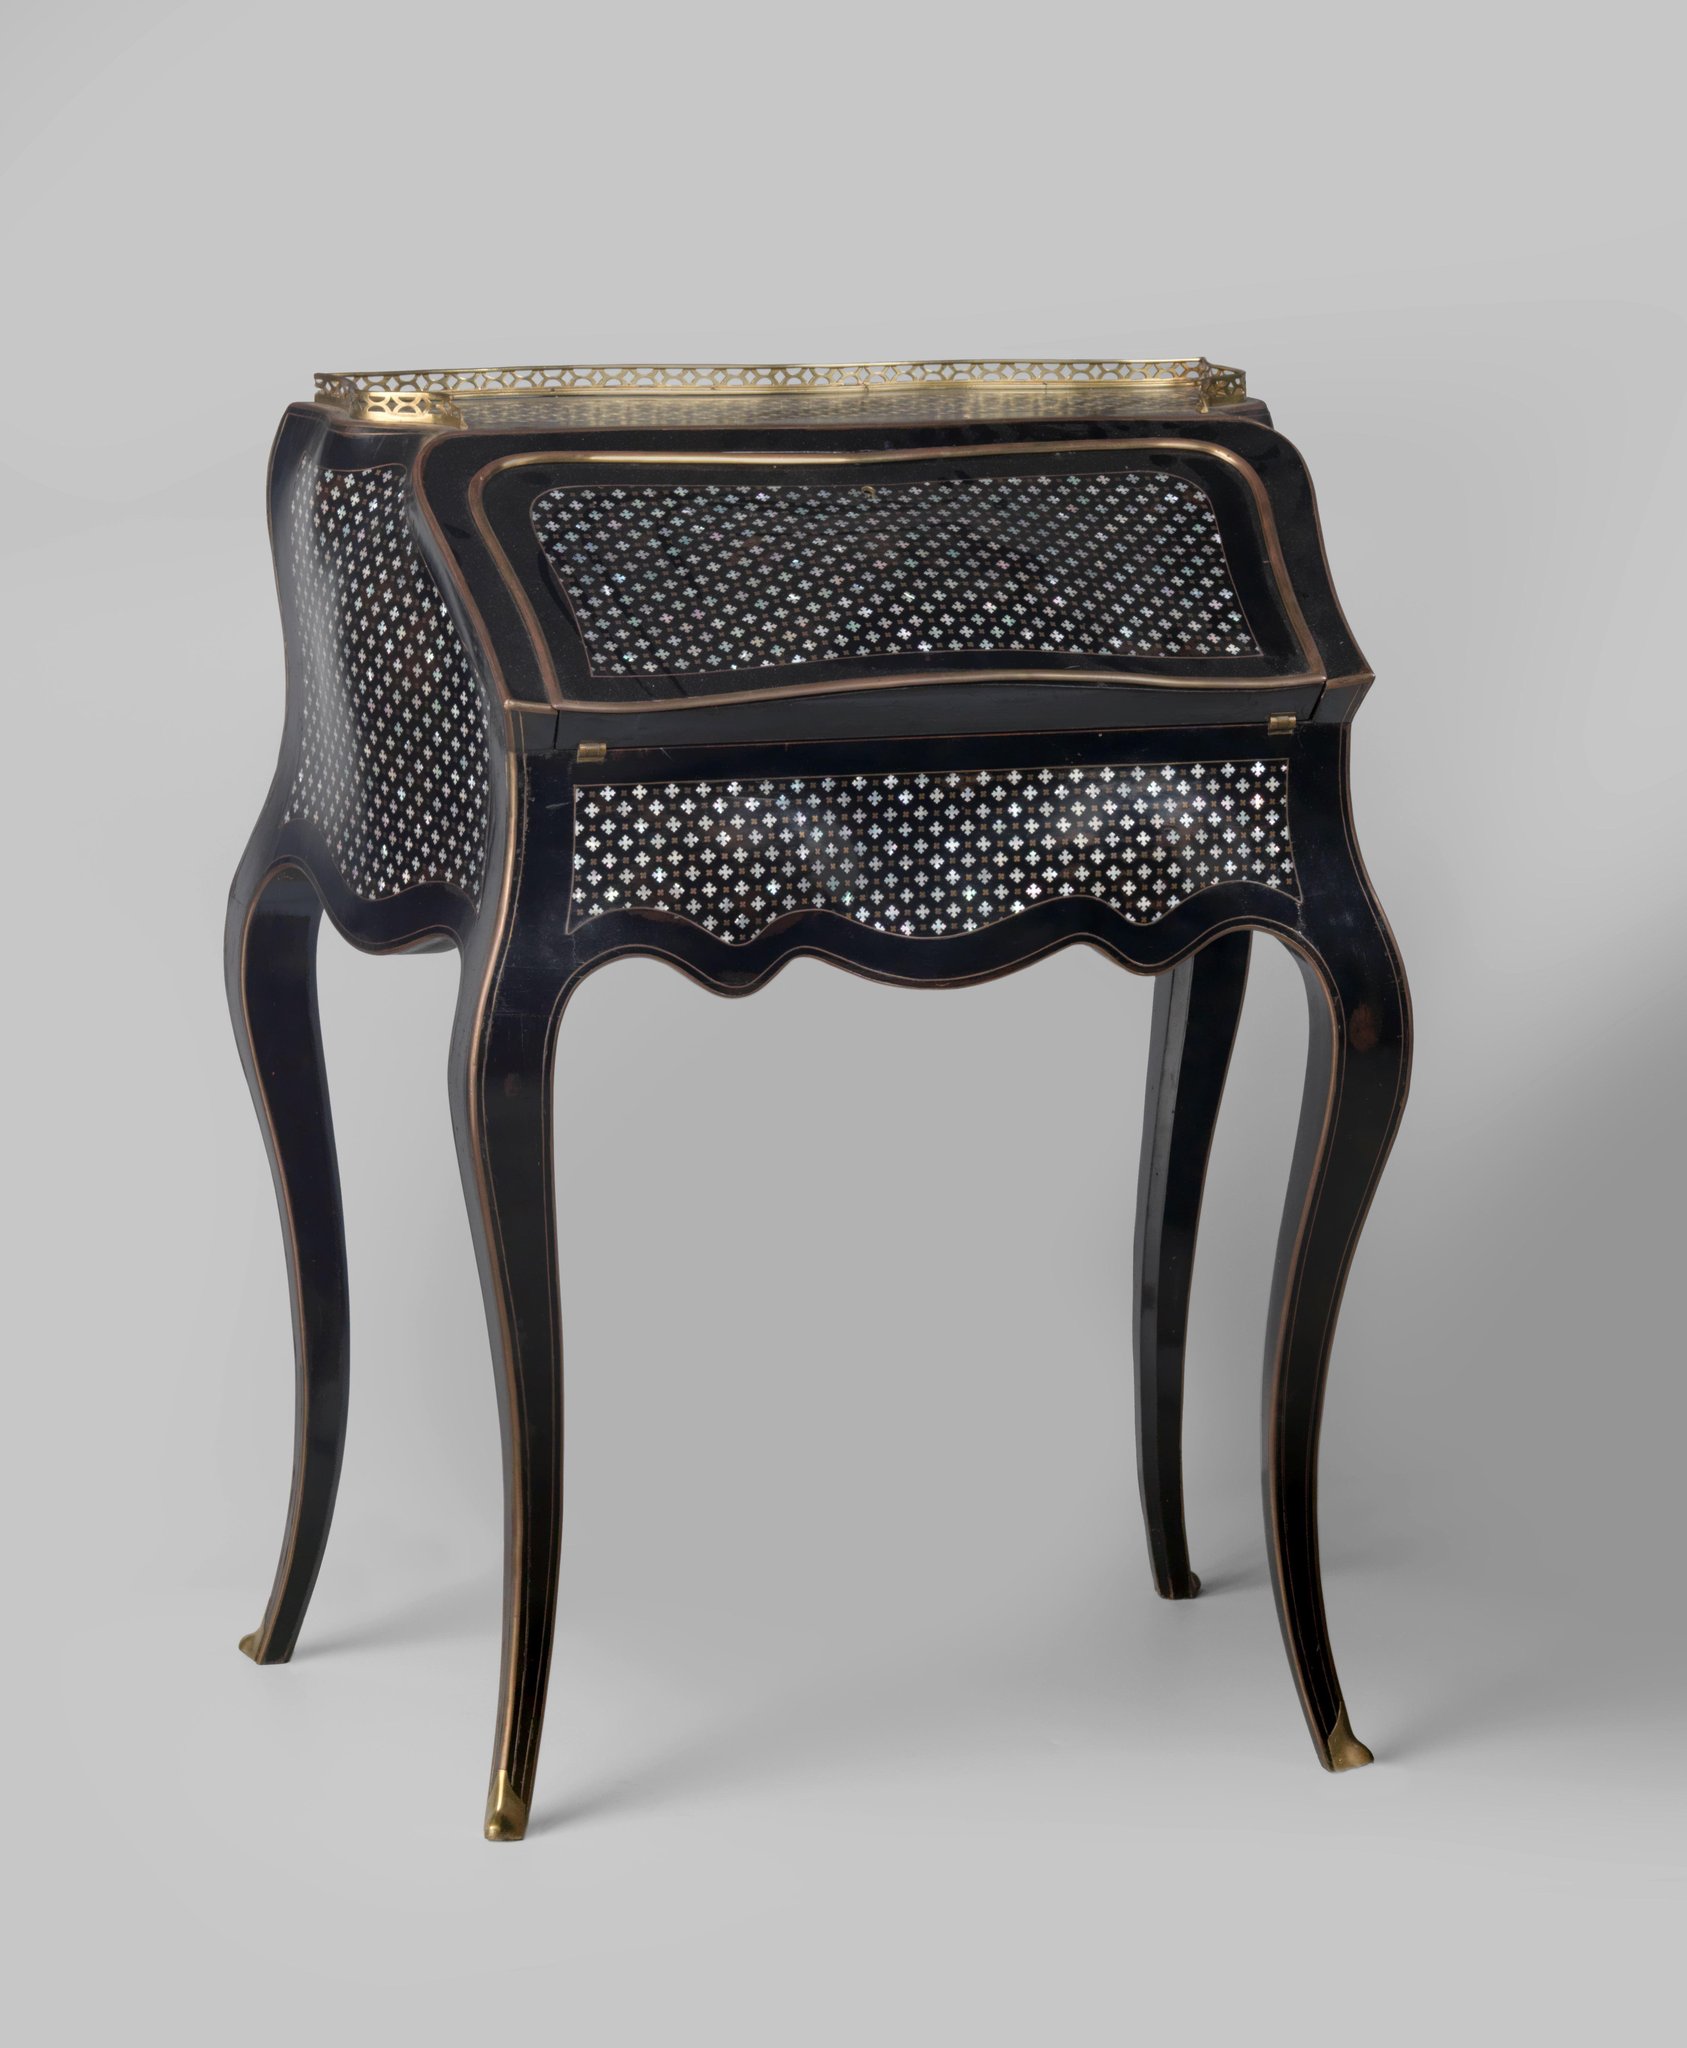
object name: furniture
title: Bureau, belijmd met verschillende houtsoorten, koper en parelmoer. Aan alle zijden gebombeerd. Versierd met kruis- en klaverbladvormige motieven. Biezen van koper.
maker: Anonymous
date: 1850-1875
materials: bronze, copper, wood, mother of pearl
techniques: gilding, veneer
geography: france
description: Lady's desk, oak, veneered with black-coloured wood, inlaid with mother-of-pearl and brass Paris, c. 1850 - 1875 This desk, an example of standard French furniture-making, is closely related to the table in the design by M. Pagny shown nearby.